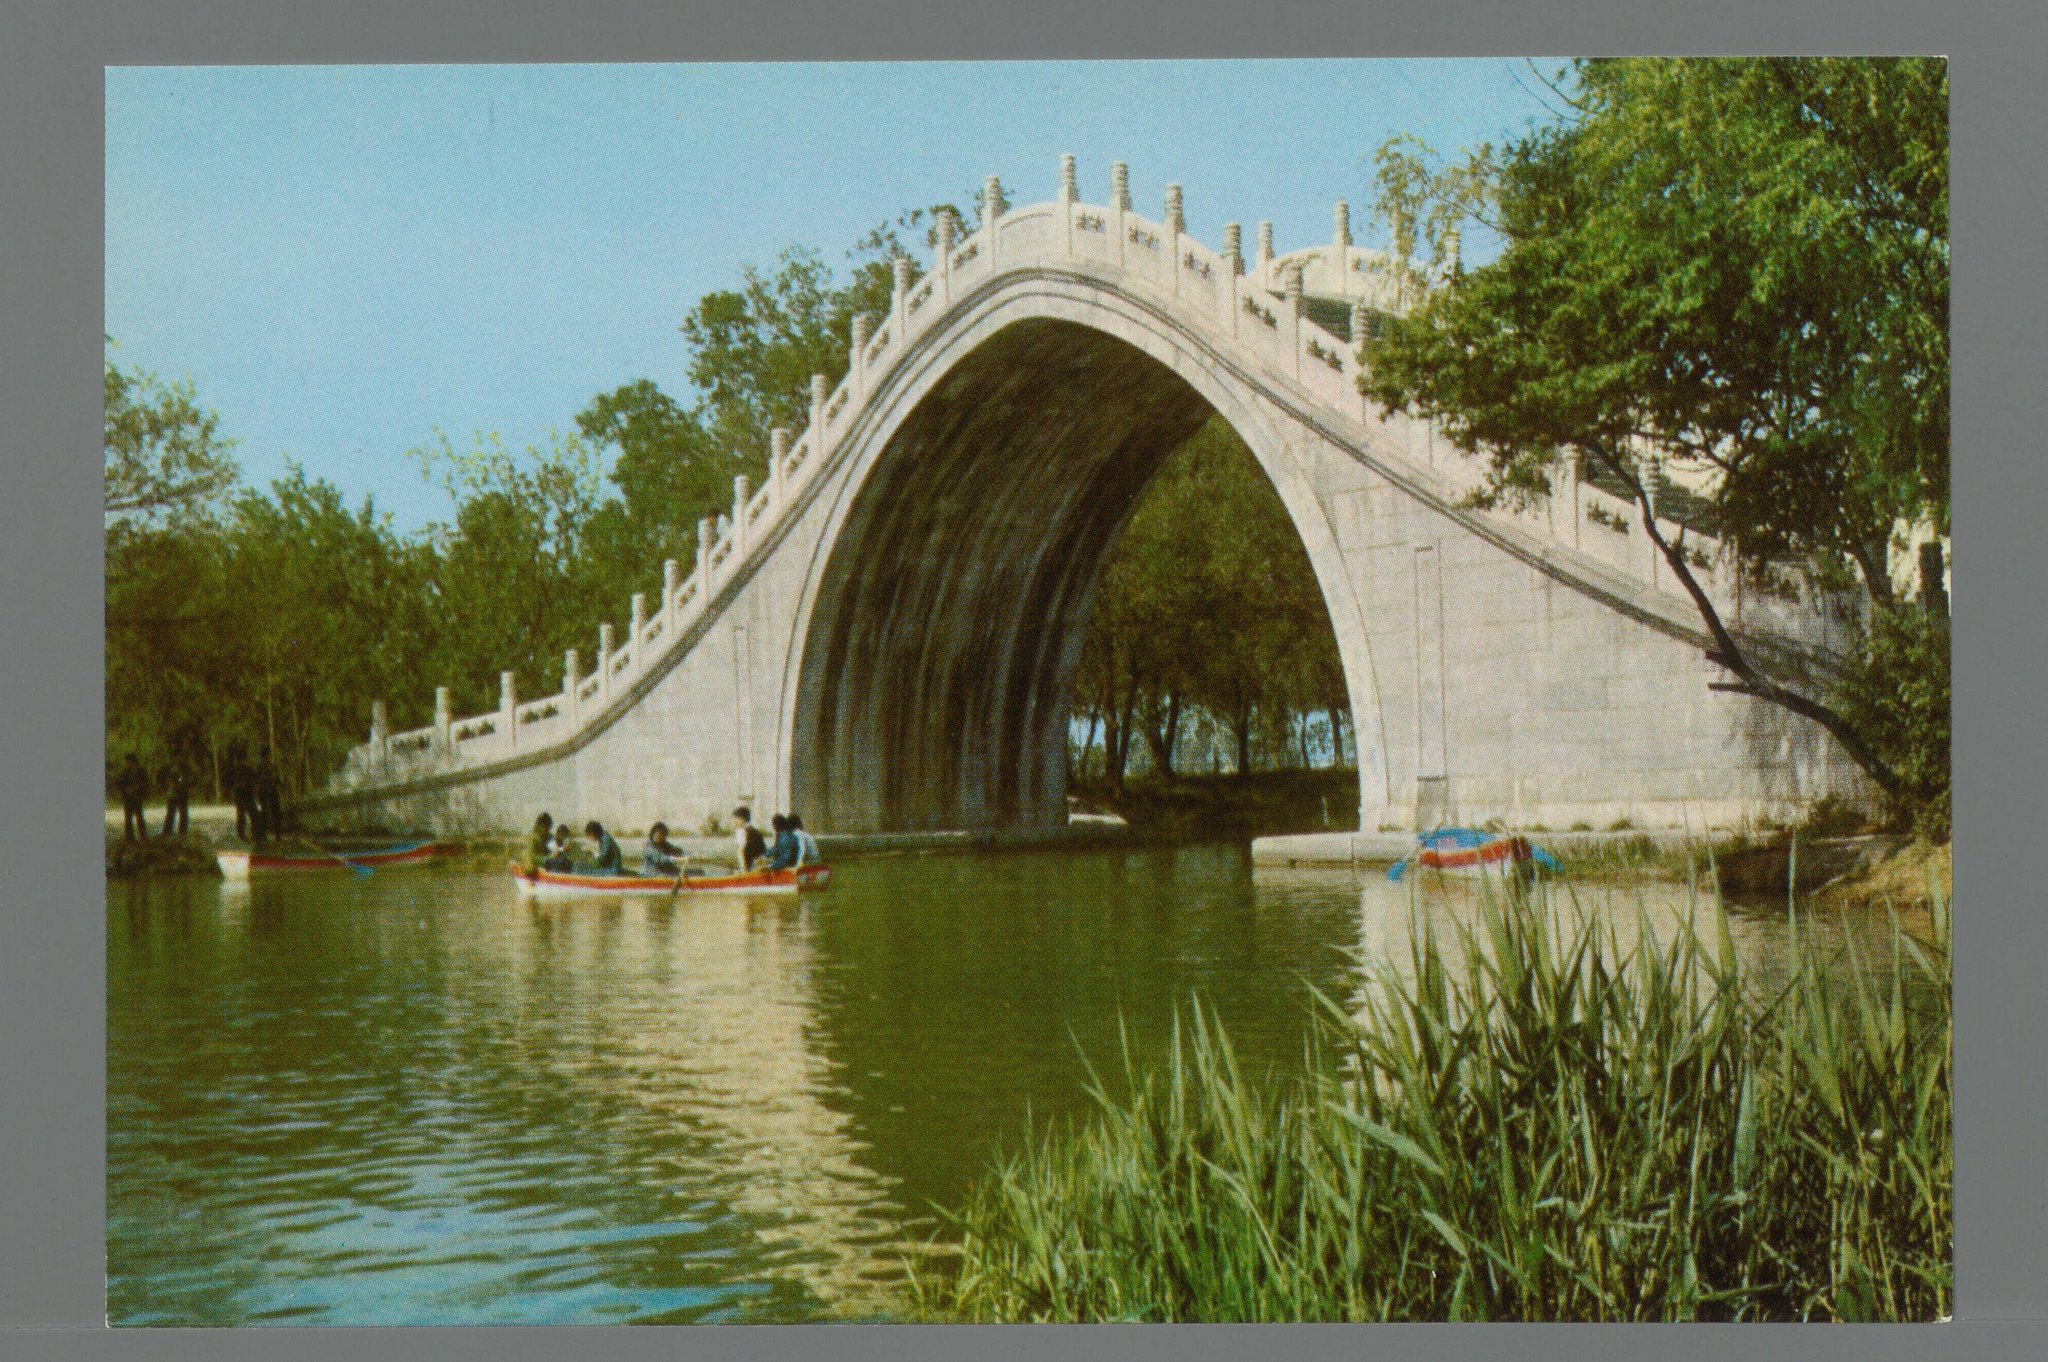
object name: photomechanical print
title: The Summer Palace, Peking / Vues du Palais d'Eté de Pékin / Vista del Palacio de Verano, Pekin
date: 1974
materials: cardboard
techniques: offset printed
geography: beijing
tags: palace, lake, bridge